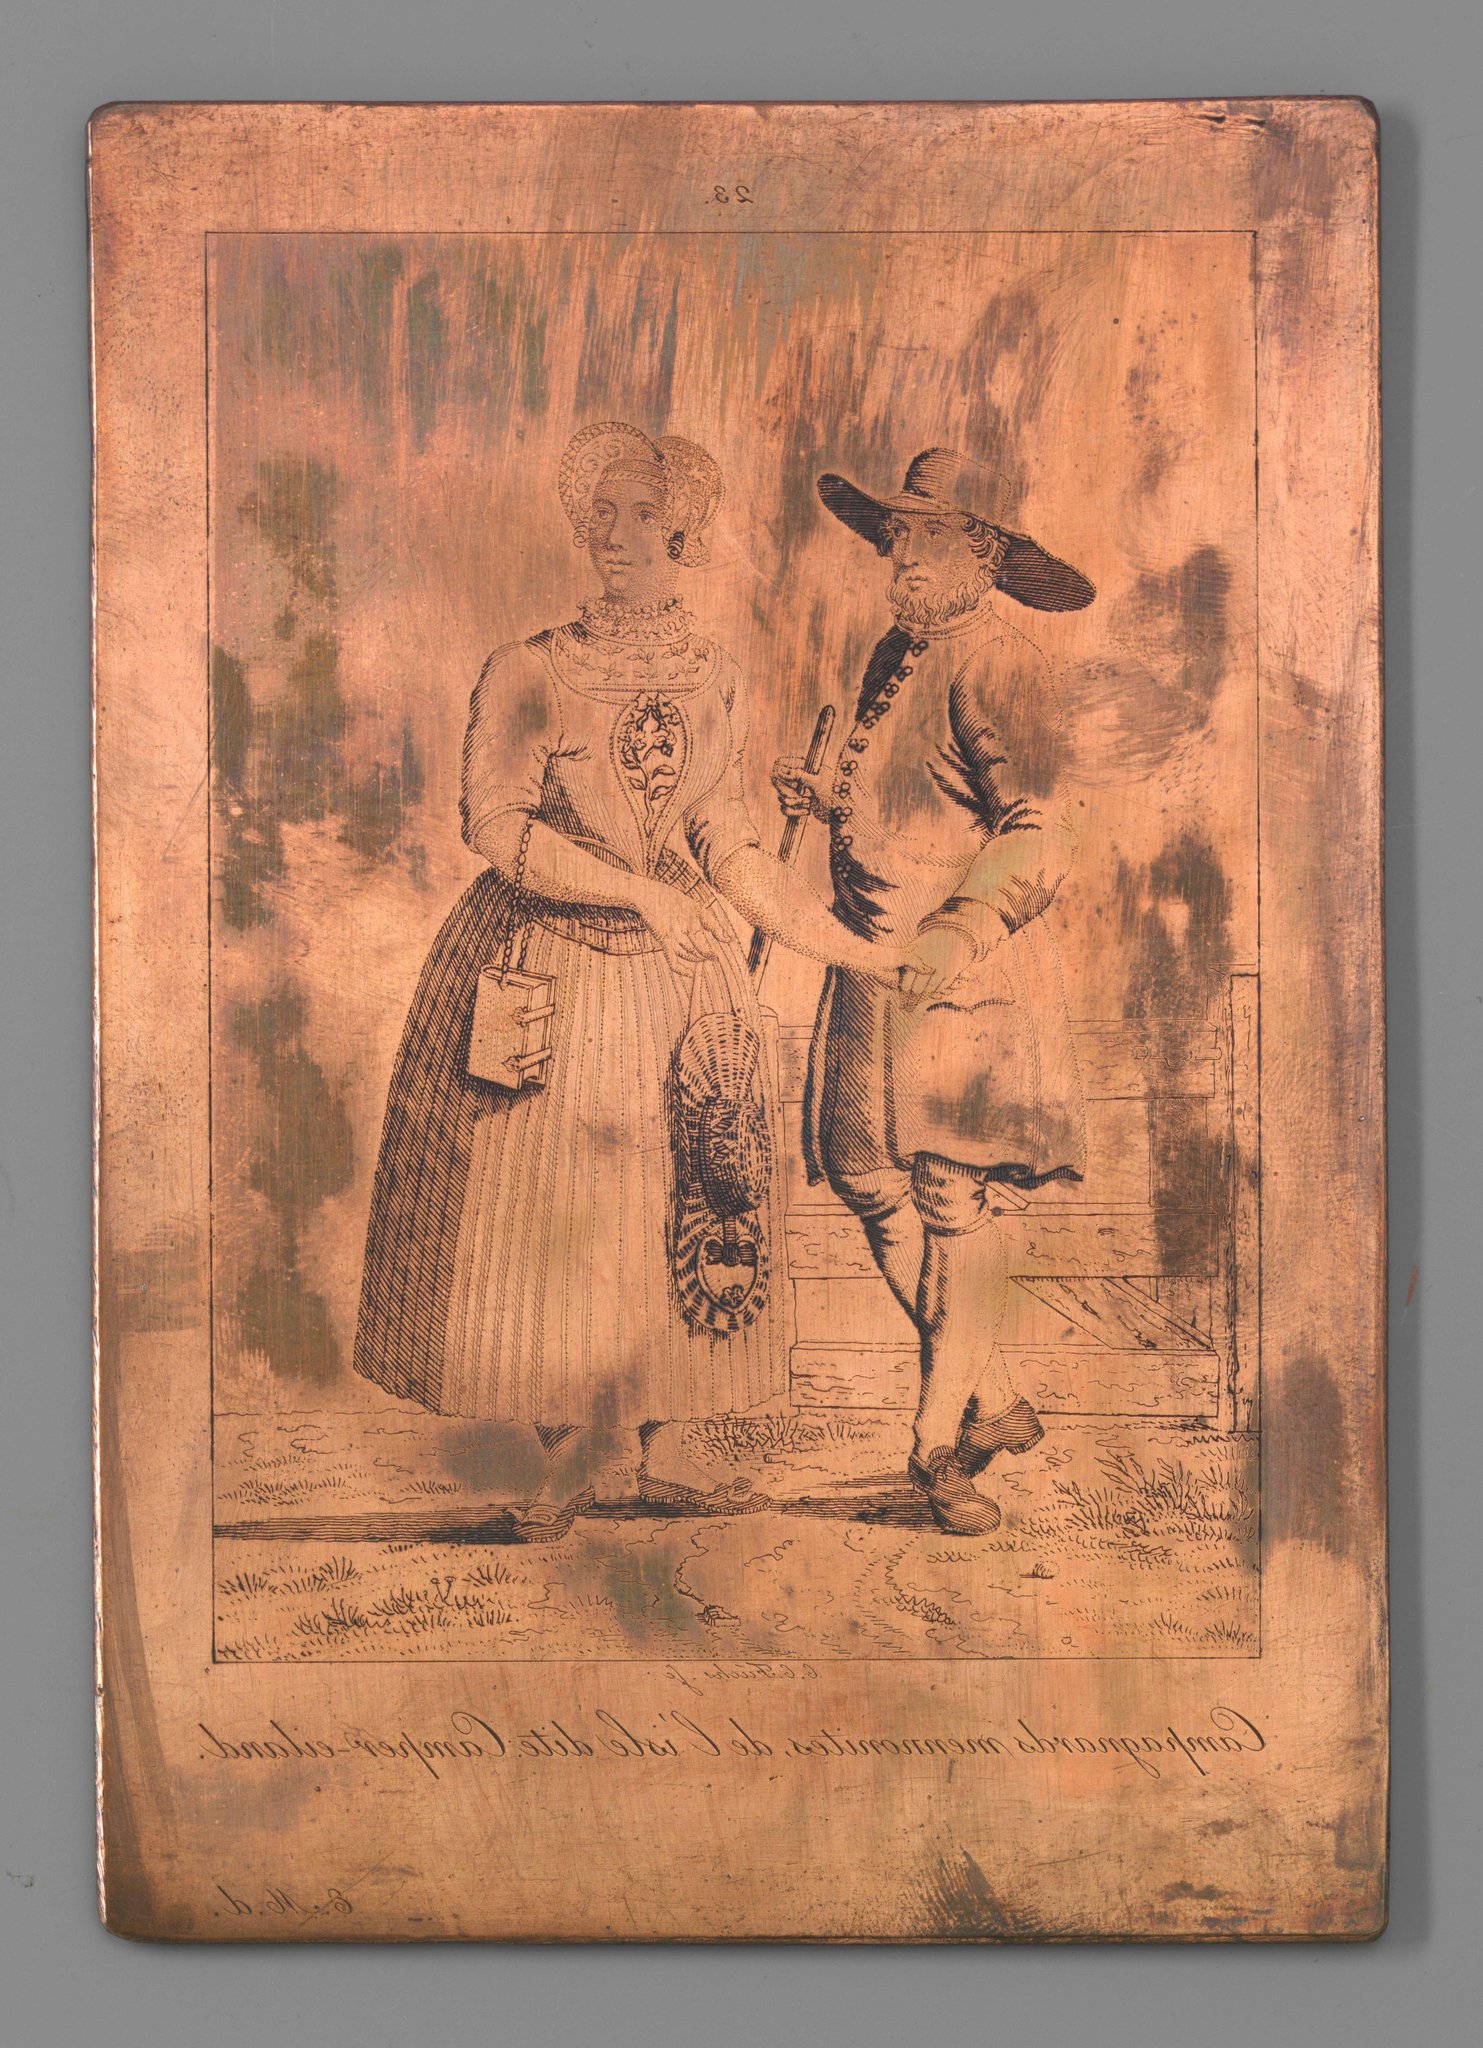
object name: copper plate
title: Campagnards menonites, de l'isle dite Camper-eiland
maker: karel christiaan fuchs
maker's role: draughtsman, print maker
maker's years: 1792-1855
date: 1802-1855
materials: copper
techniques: etching